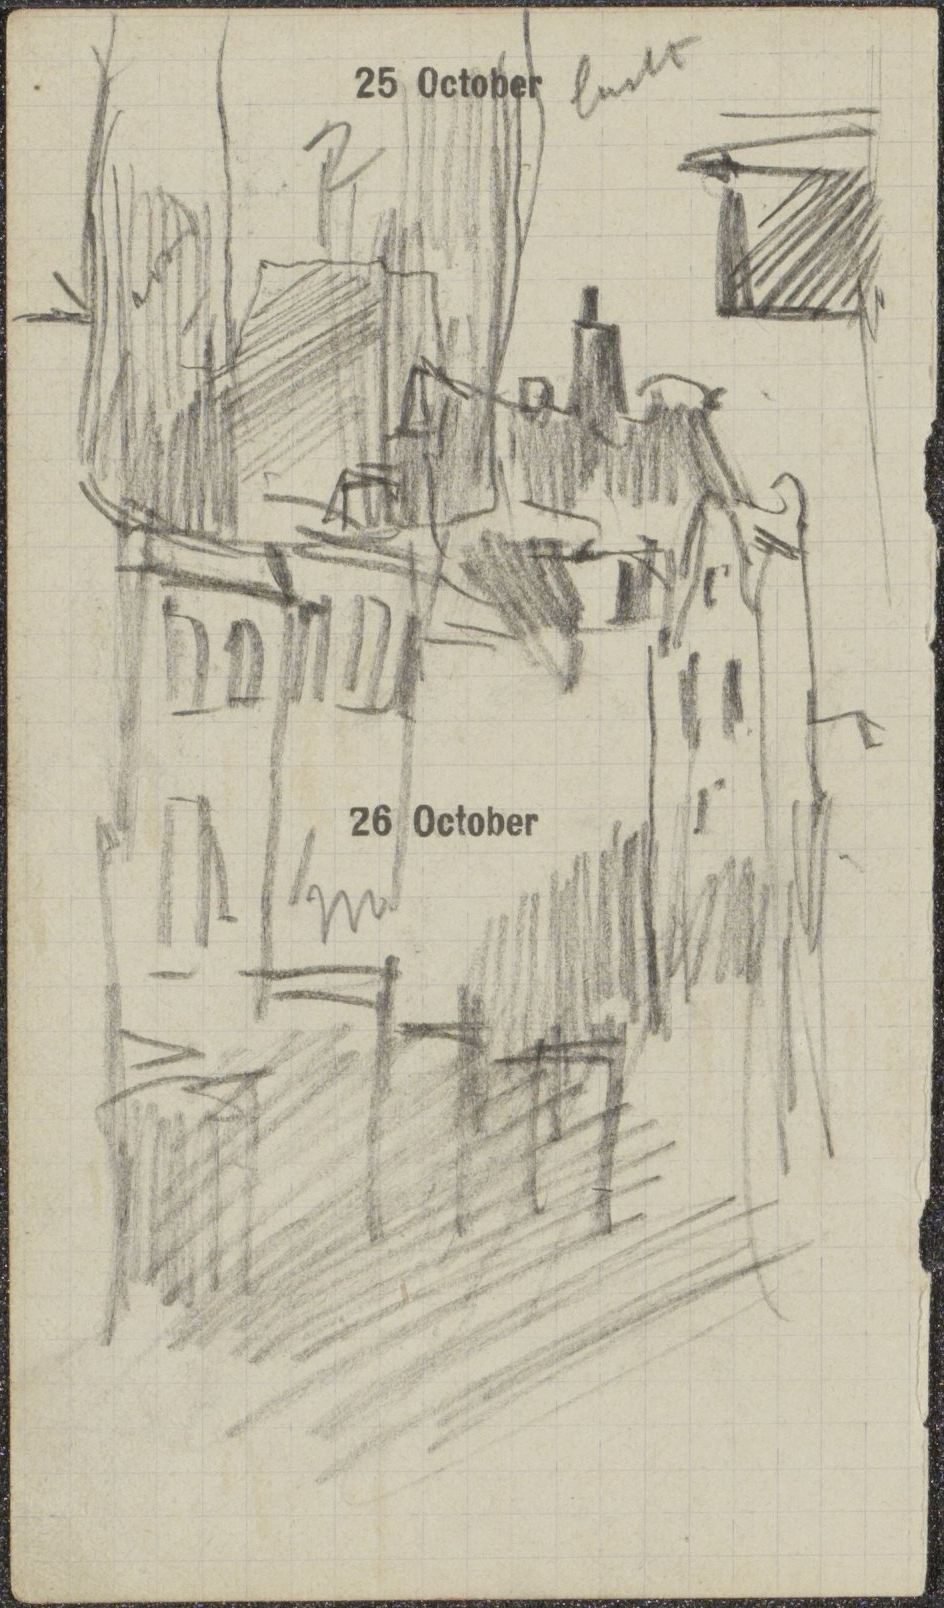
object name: drawing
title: Huizenrij in de Paleisstraat te Amsterdam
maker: george hendrik breitner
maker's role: draughtsman, painter, print maker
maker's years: 1857-1923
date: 1886-1923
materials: chalk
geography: amsterdam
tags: urban housing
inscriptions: annotation: ‘[...]/ f 10 huishouden/ 2’